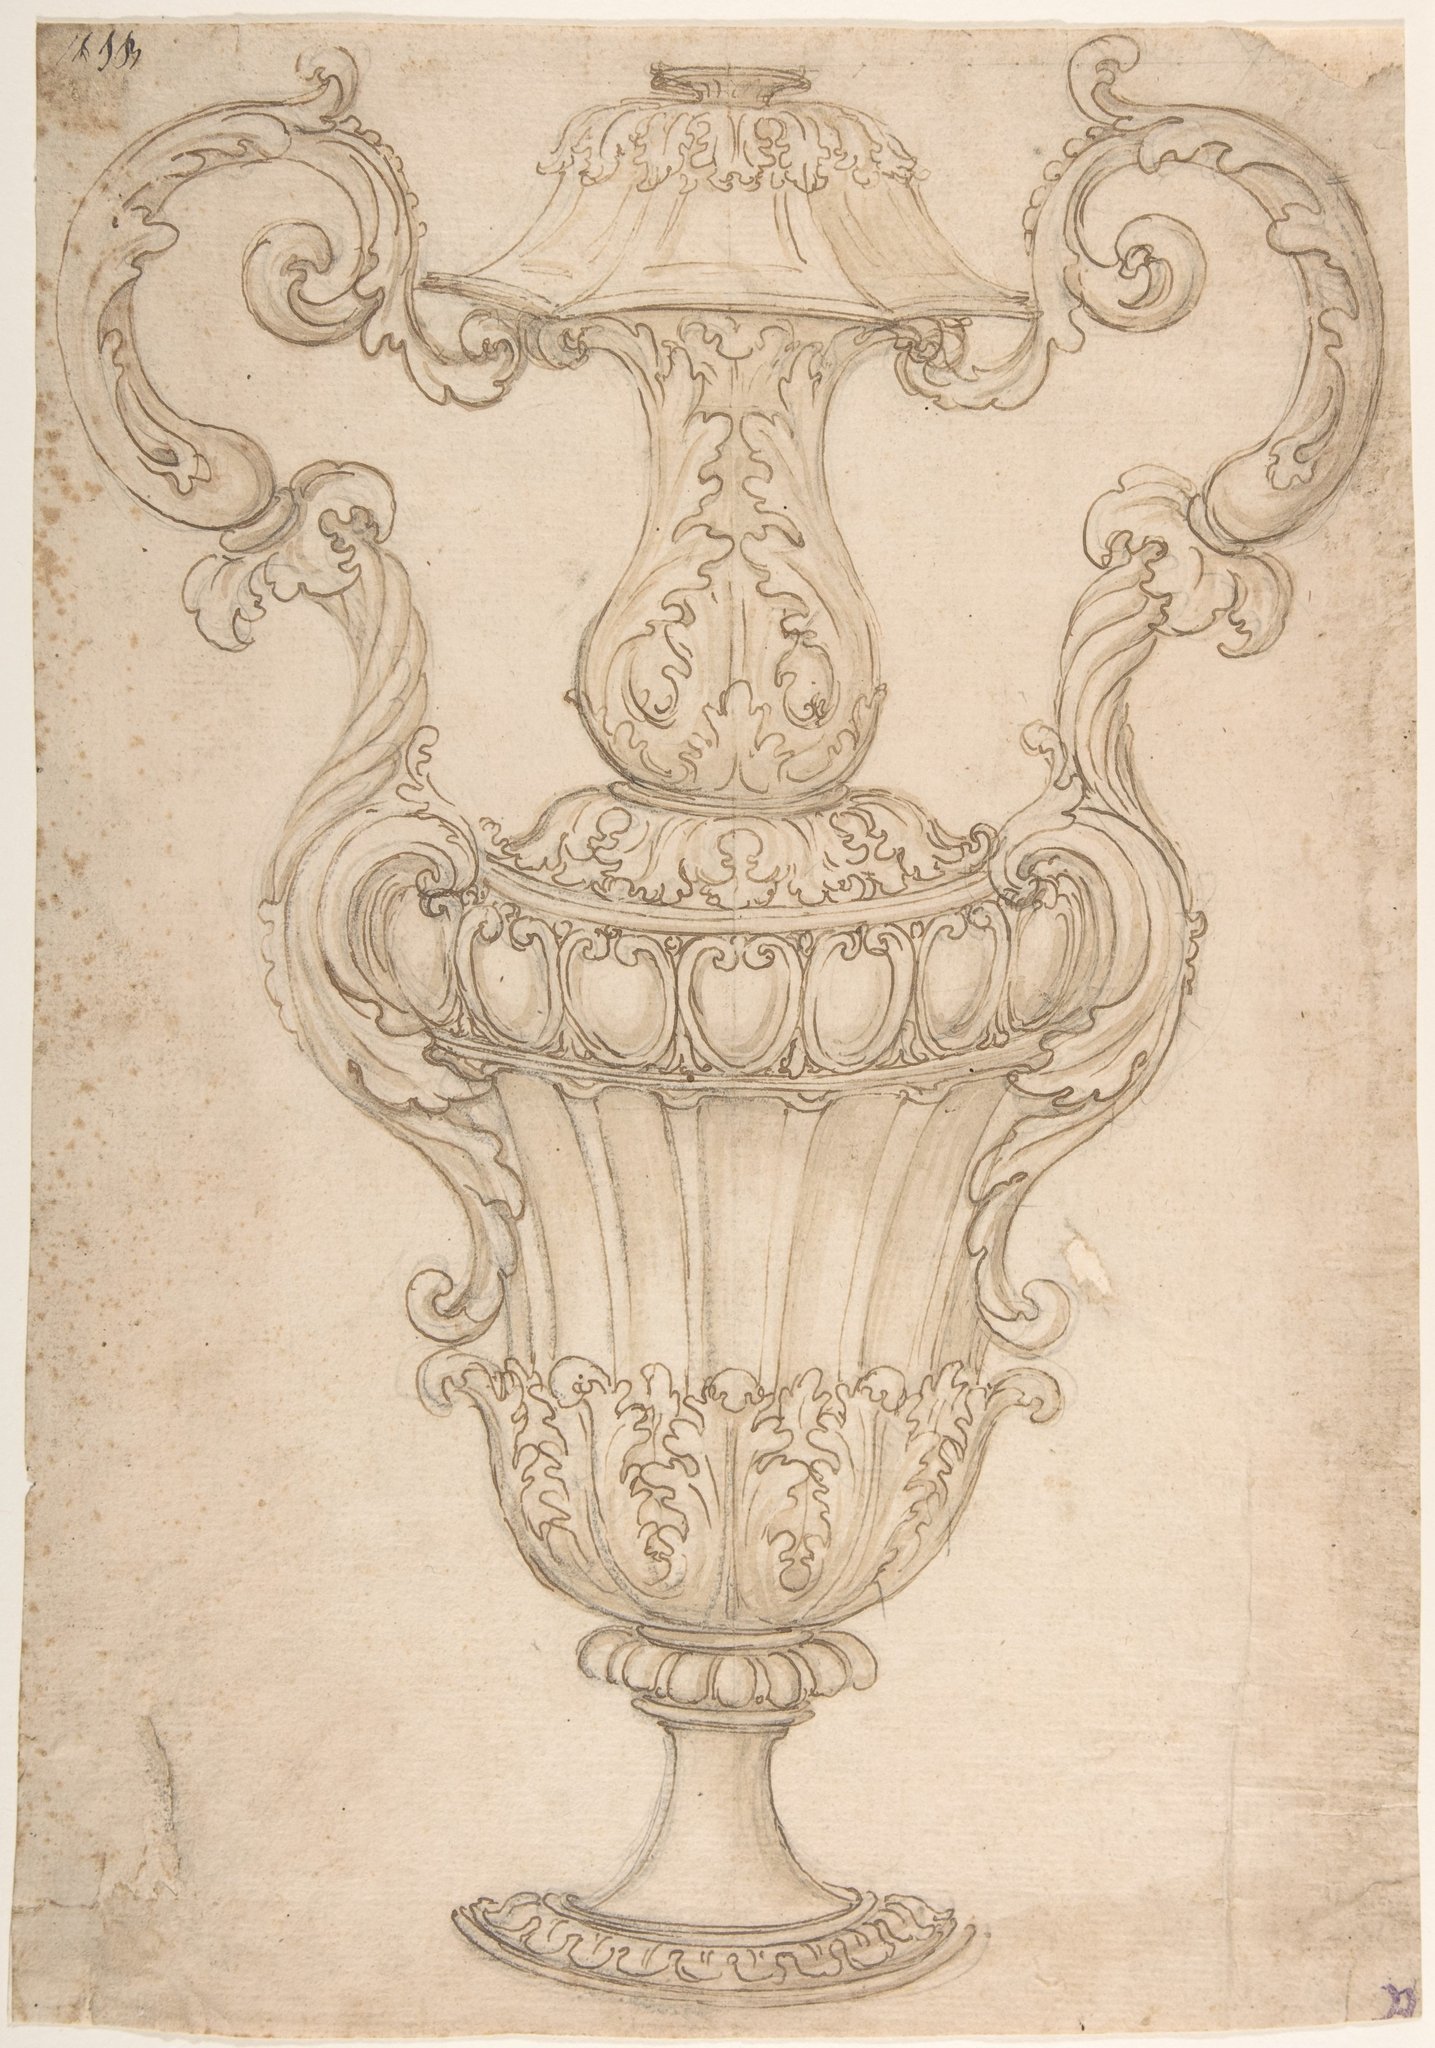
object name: drawing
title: Design for a Two-Handled Urn with Acanthus, Shell, and Egg-and-Tongue Motif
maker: giovanni battista foggini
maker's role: artist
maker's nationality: italian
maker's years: 1652-1725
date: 1672-1725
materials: chalk, graphite, ink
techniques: brush, pen, wash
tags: urns